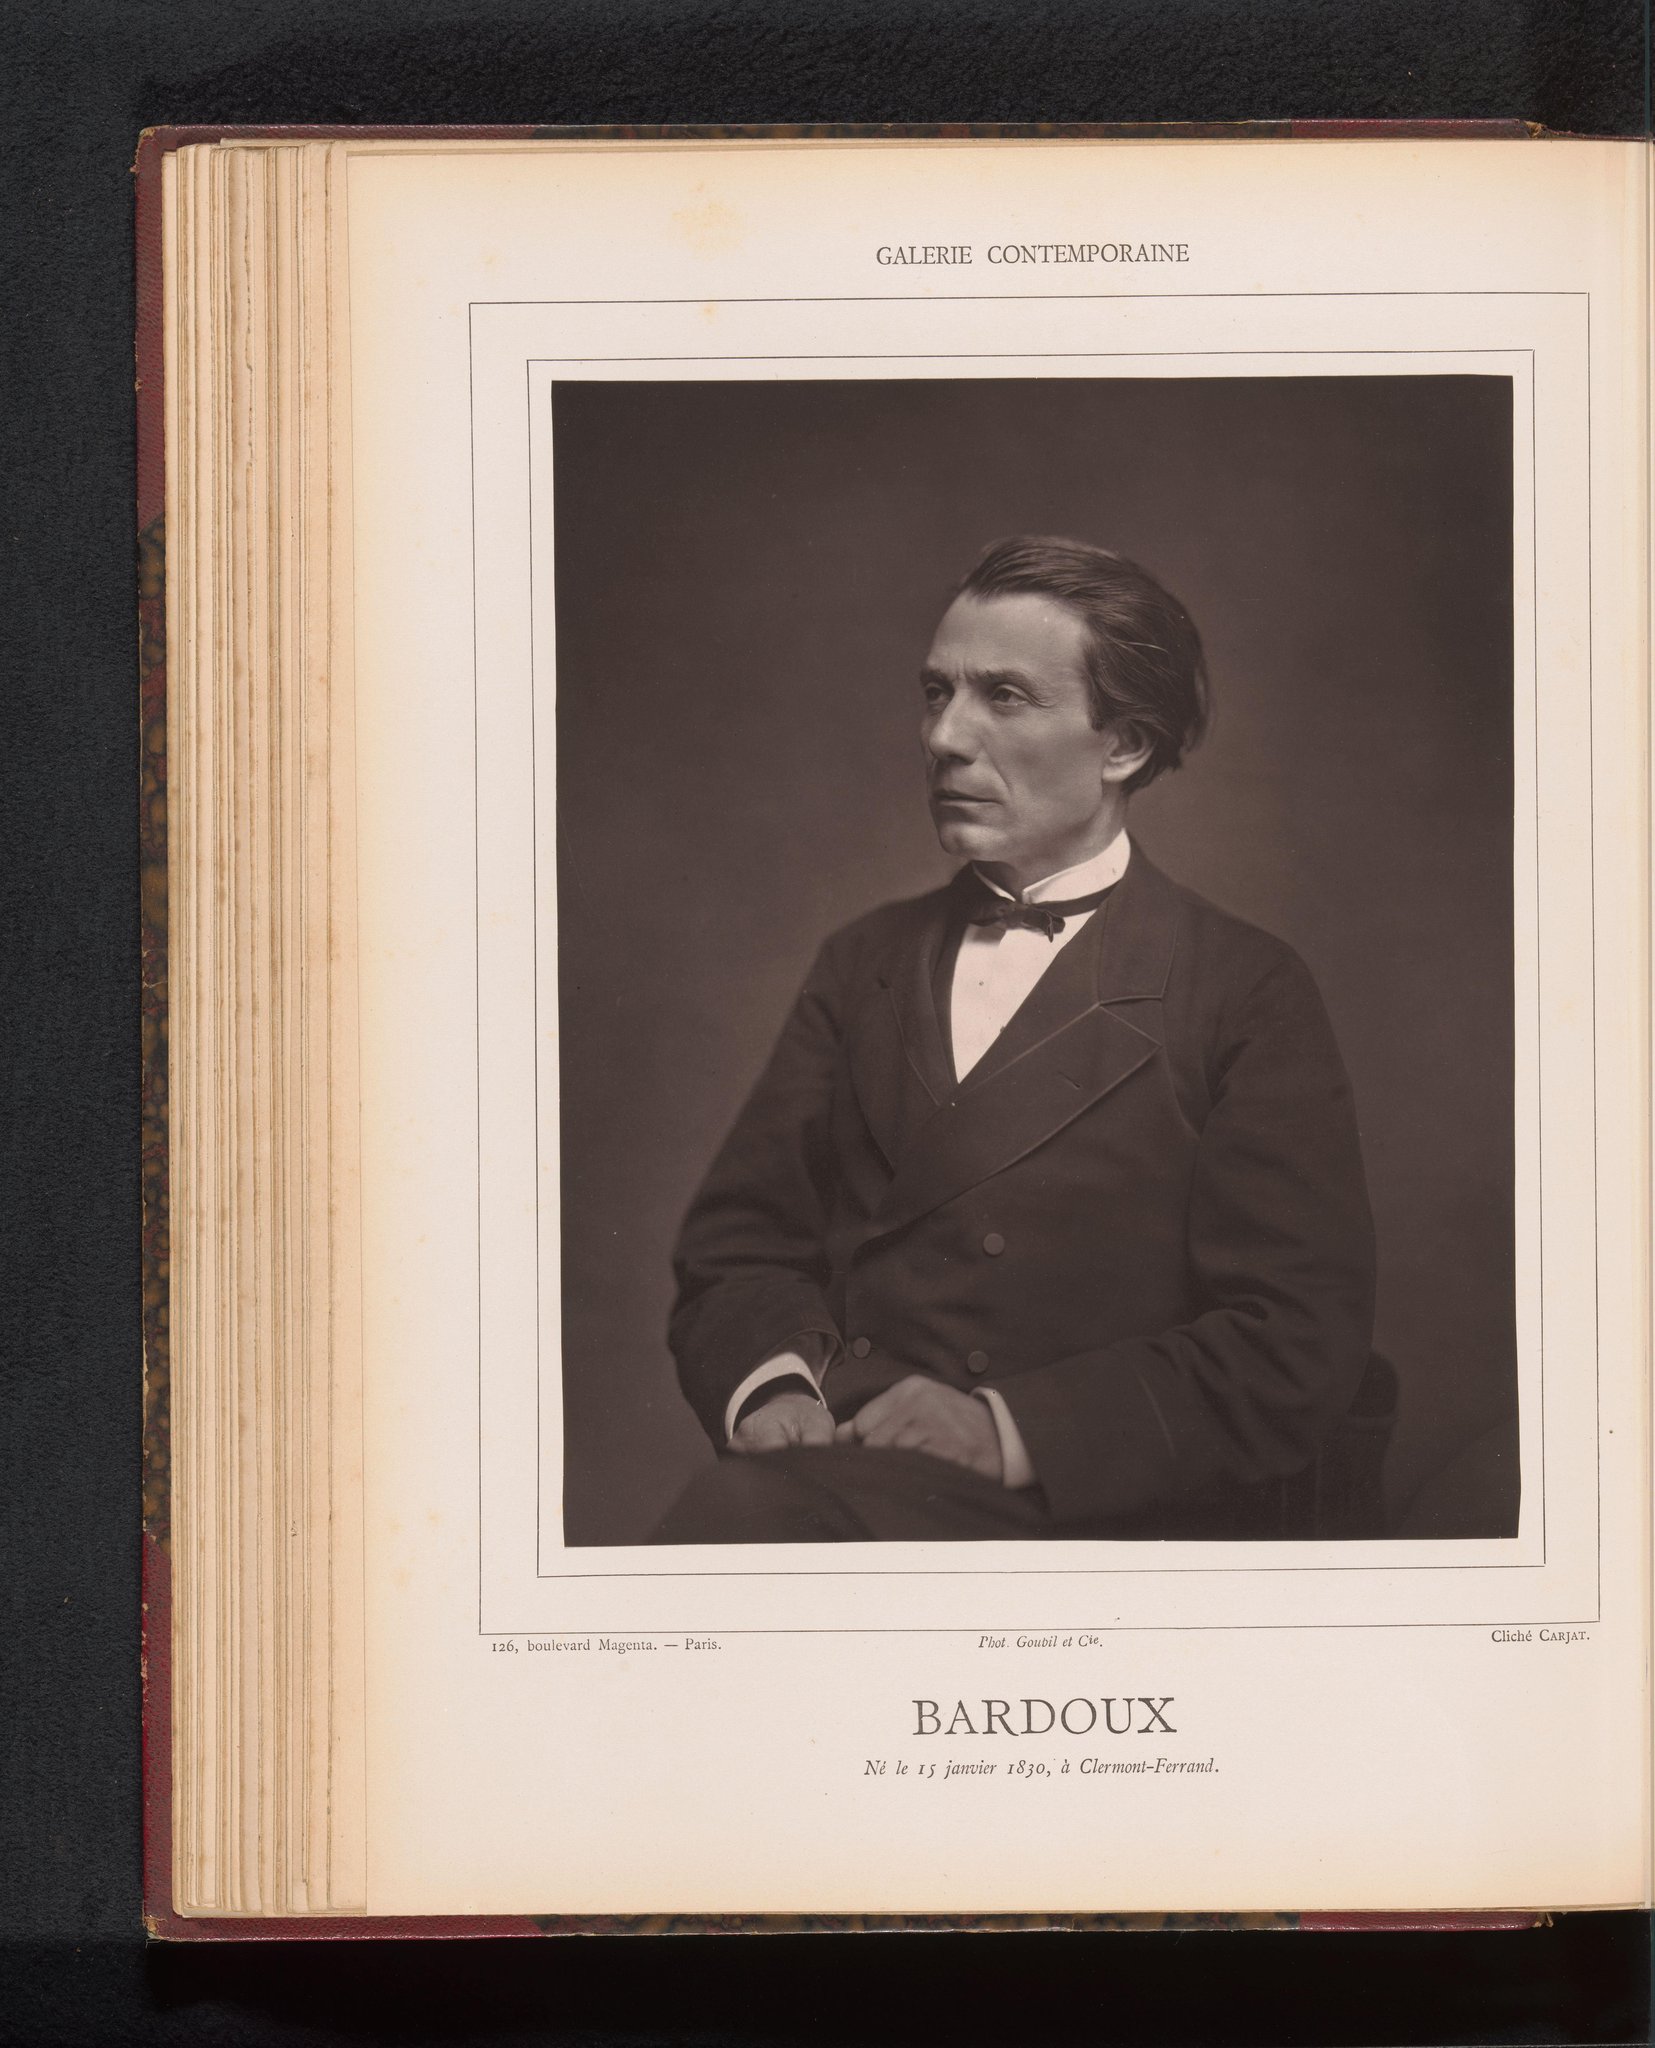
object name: photomechanical print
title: Portret van Agénor Bardoux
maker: étienne carjat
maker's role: draughtsman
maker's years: 1828-1906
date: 1873-1878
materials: paper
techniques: woodburytype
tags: paris, politician, adult man, historical persons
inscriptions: inscription: ‘Galerie Contemporaine/ 126, boulevard Magenta. - Paris./ Né le 15 janvier 1830, à Cement-Ferrand.’